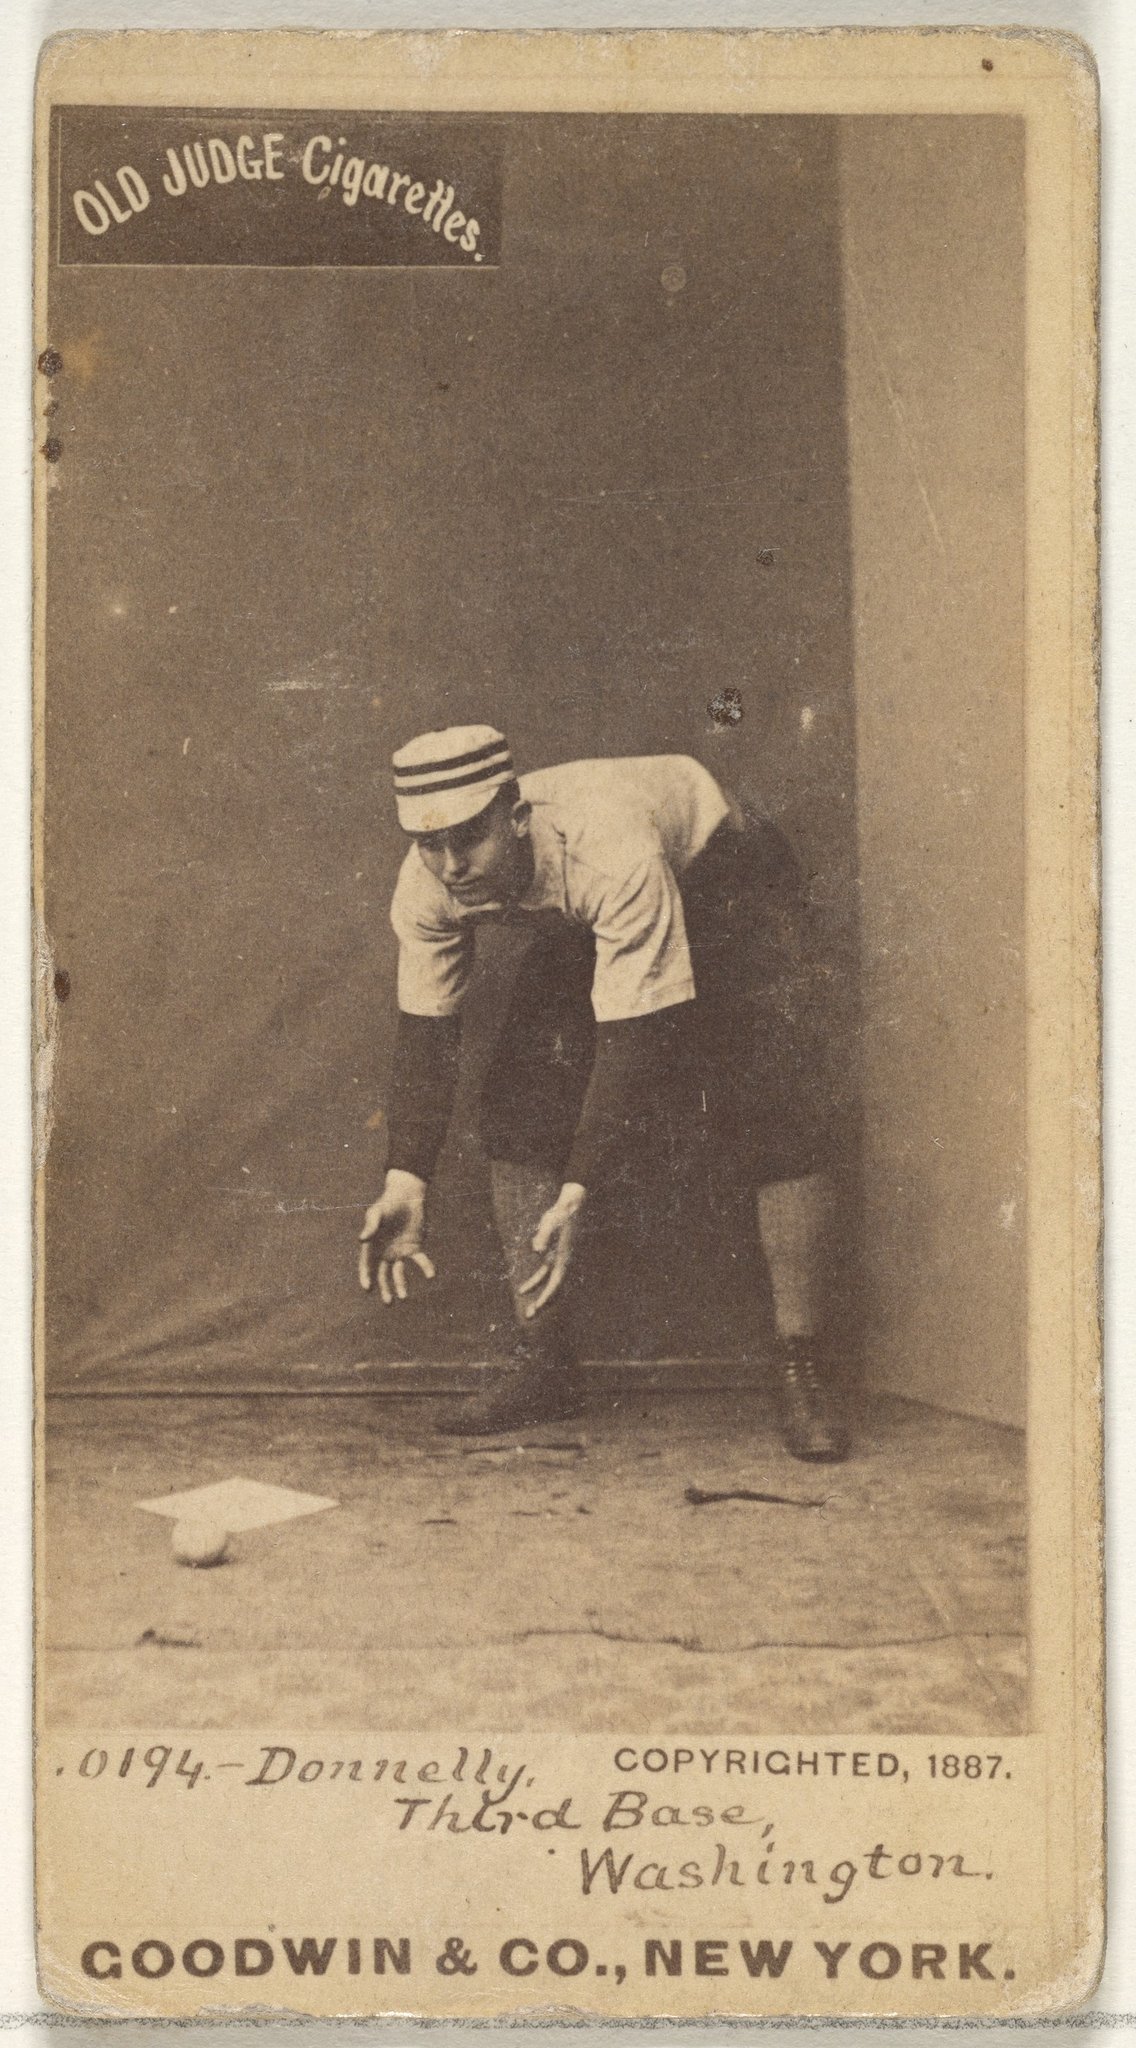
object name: baseball card, photograph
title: James B. "Jim" Donnelly, 3rd Base, Washington Nationals, from the Old Judge series (N172) for Old Judge Cigarettes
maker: goodwin & company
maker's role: publisher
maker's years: 1850-1950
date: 1887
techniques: albumen silver print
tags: men,portraits,baseball,athletes